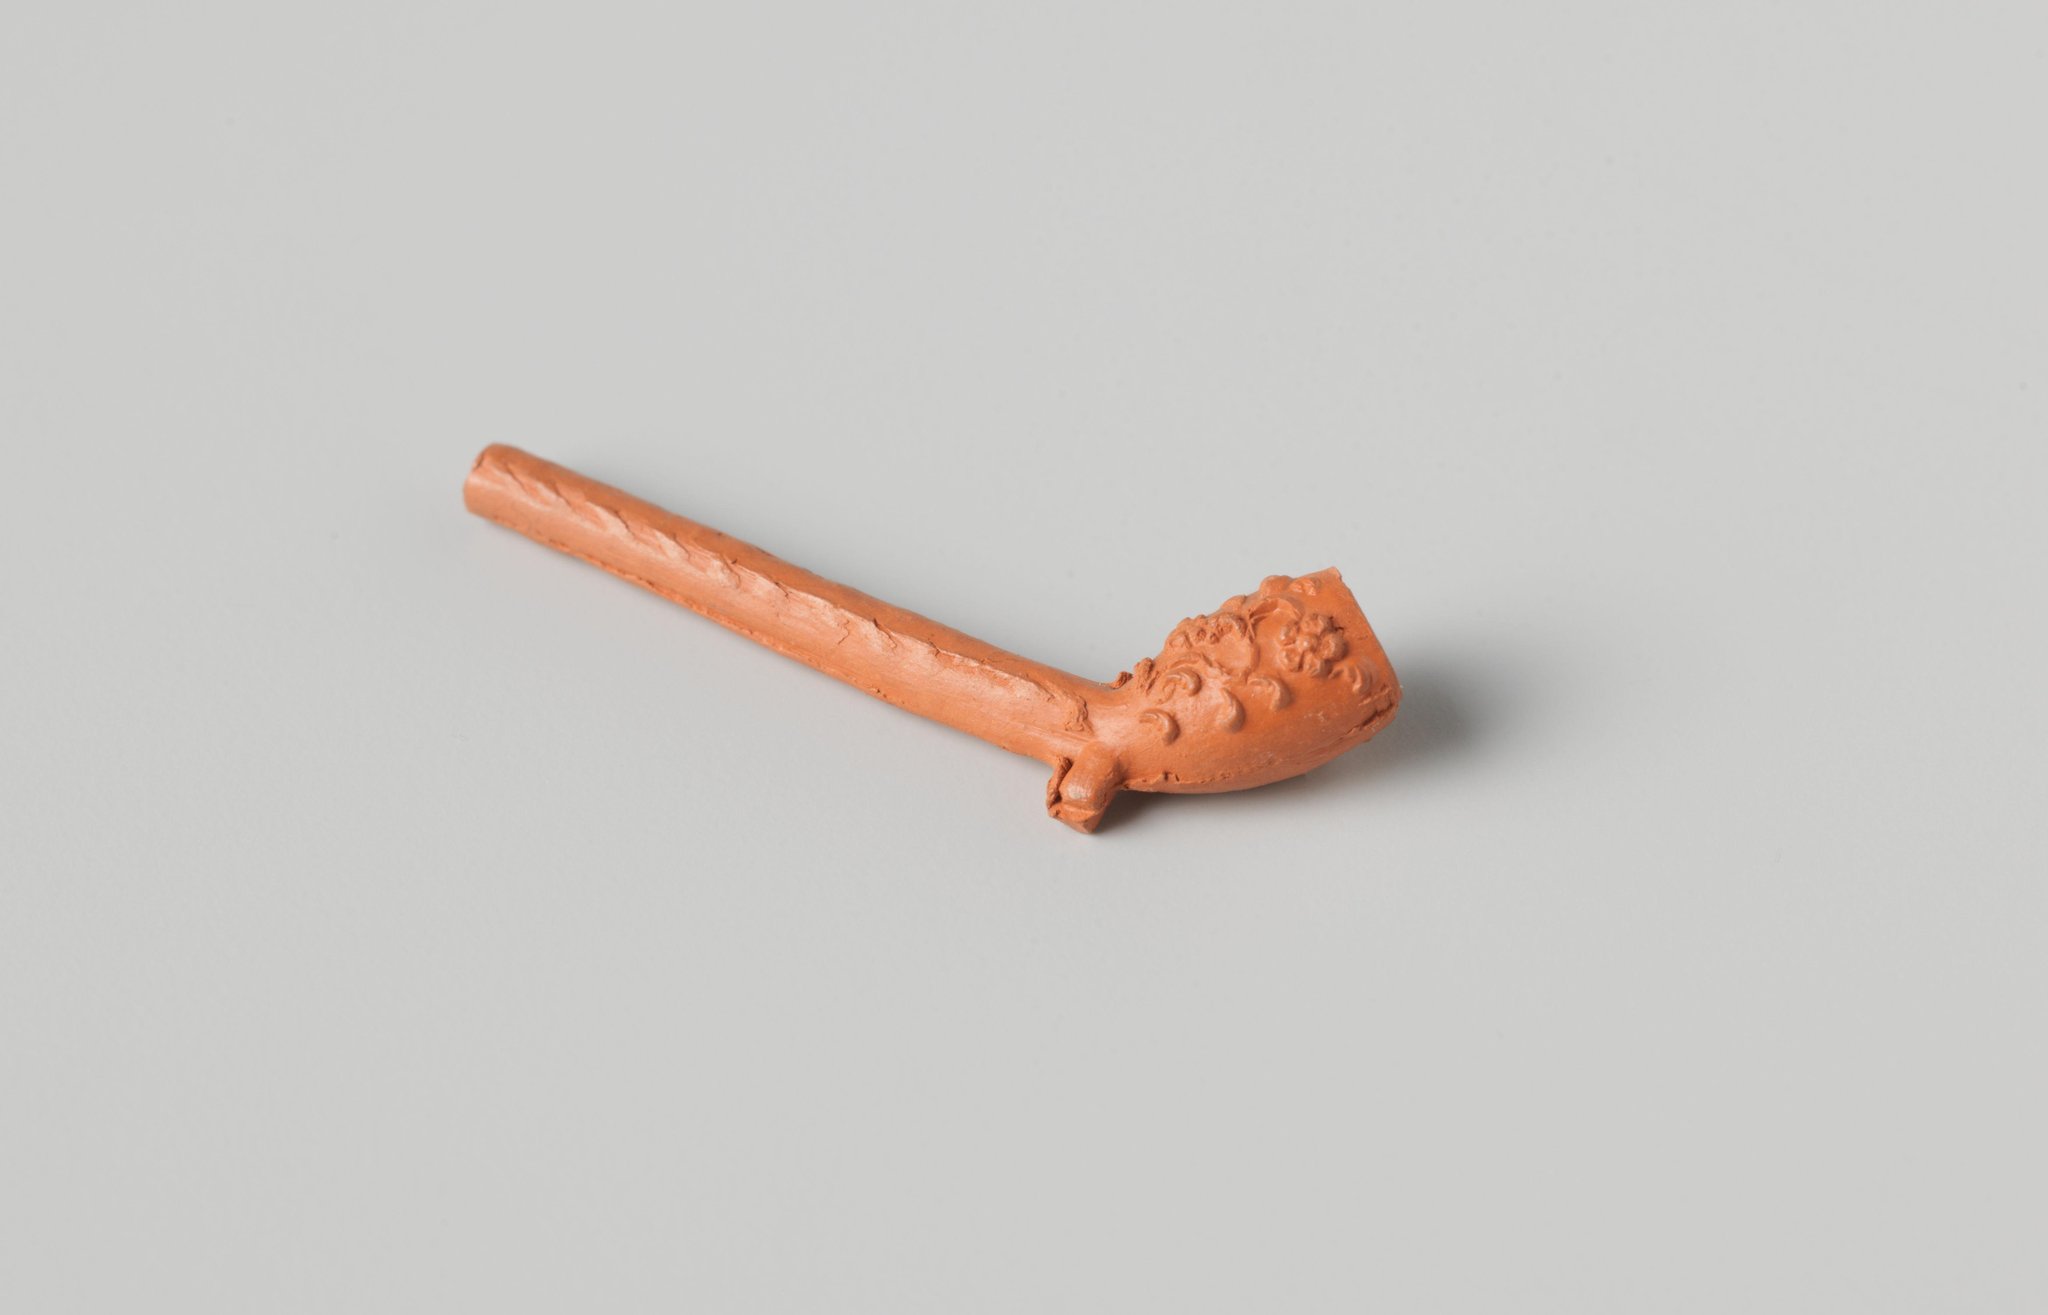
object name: miniature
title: Pijp, de kop versierd met bloemmotieven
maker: Anonymous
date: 1700-1799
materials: clay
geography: gouda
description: Pijp van rode pijpaarde, de kop versierd met fijne bloemmotieven.